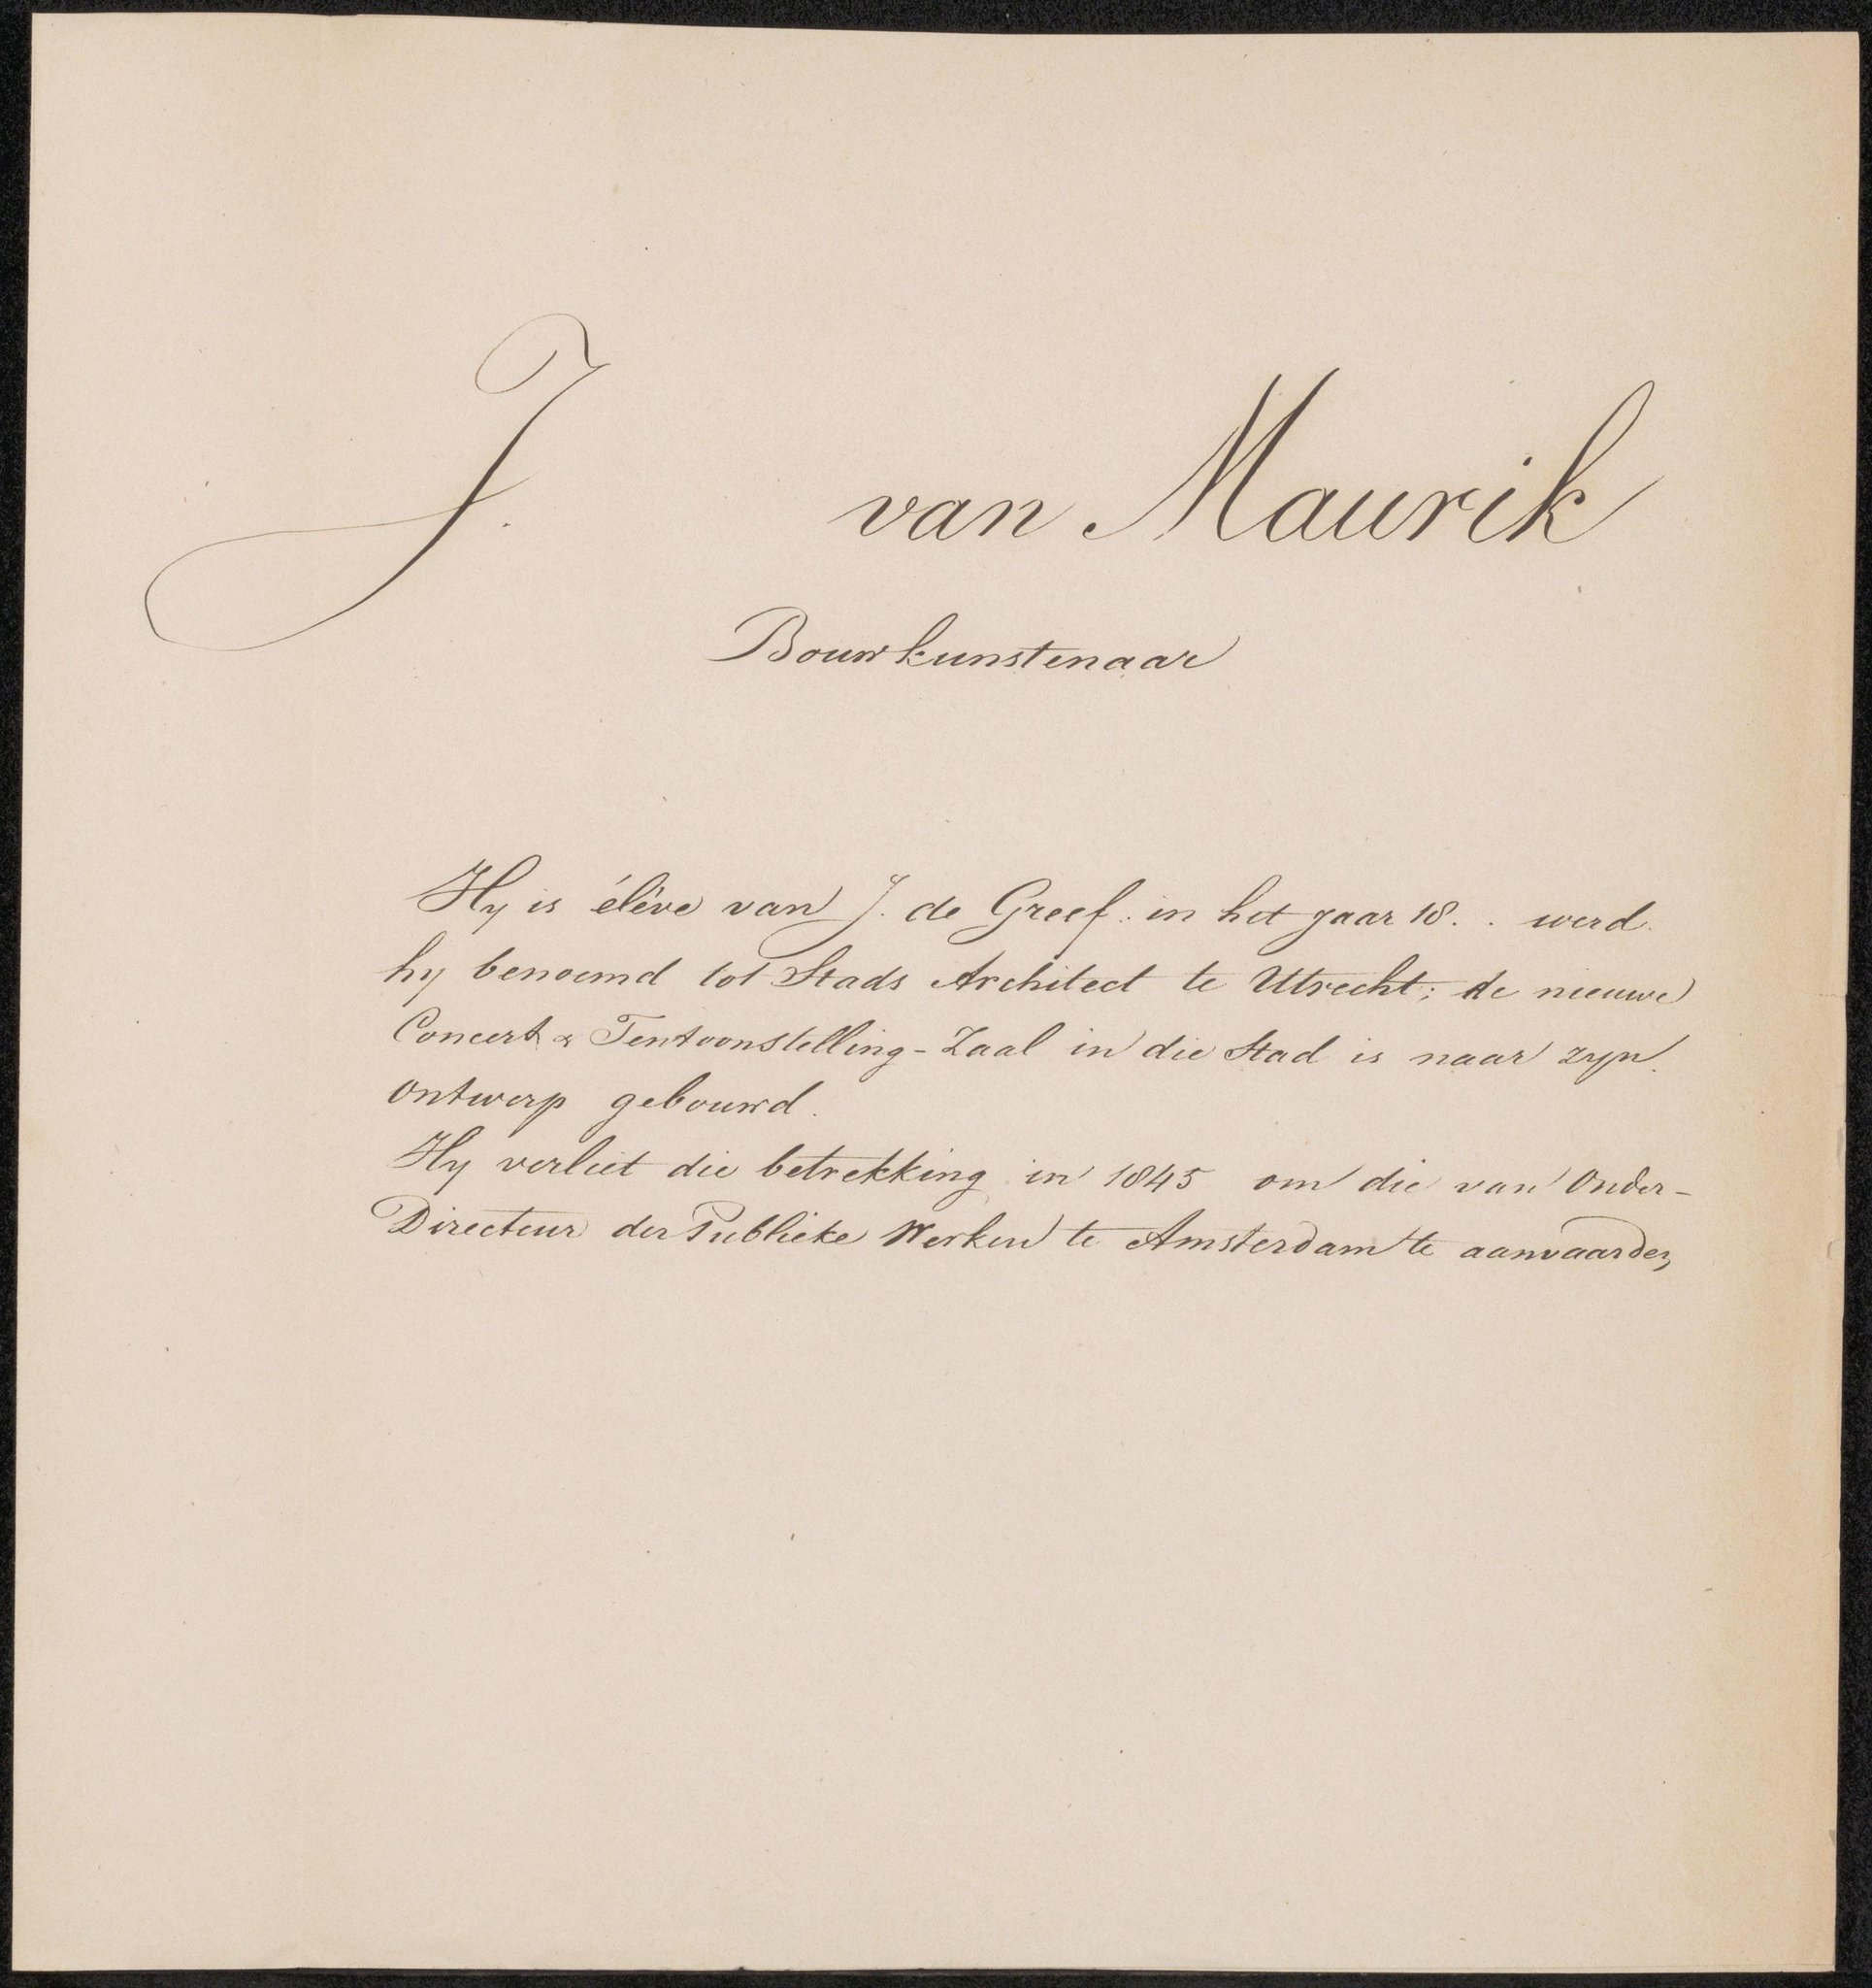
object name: aantekening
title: Aantekening betreffende Justus van Maurik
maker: Anonymous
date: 1845-1890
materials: ink, paper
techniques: pen, writing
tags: jan de greef, amsterdam, justus van maurik jr., education, tuition of the artist (in general), architecture, utrecht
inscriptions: collector's mark: ‘RPK’